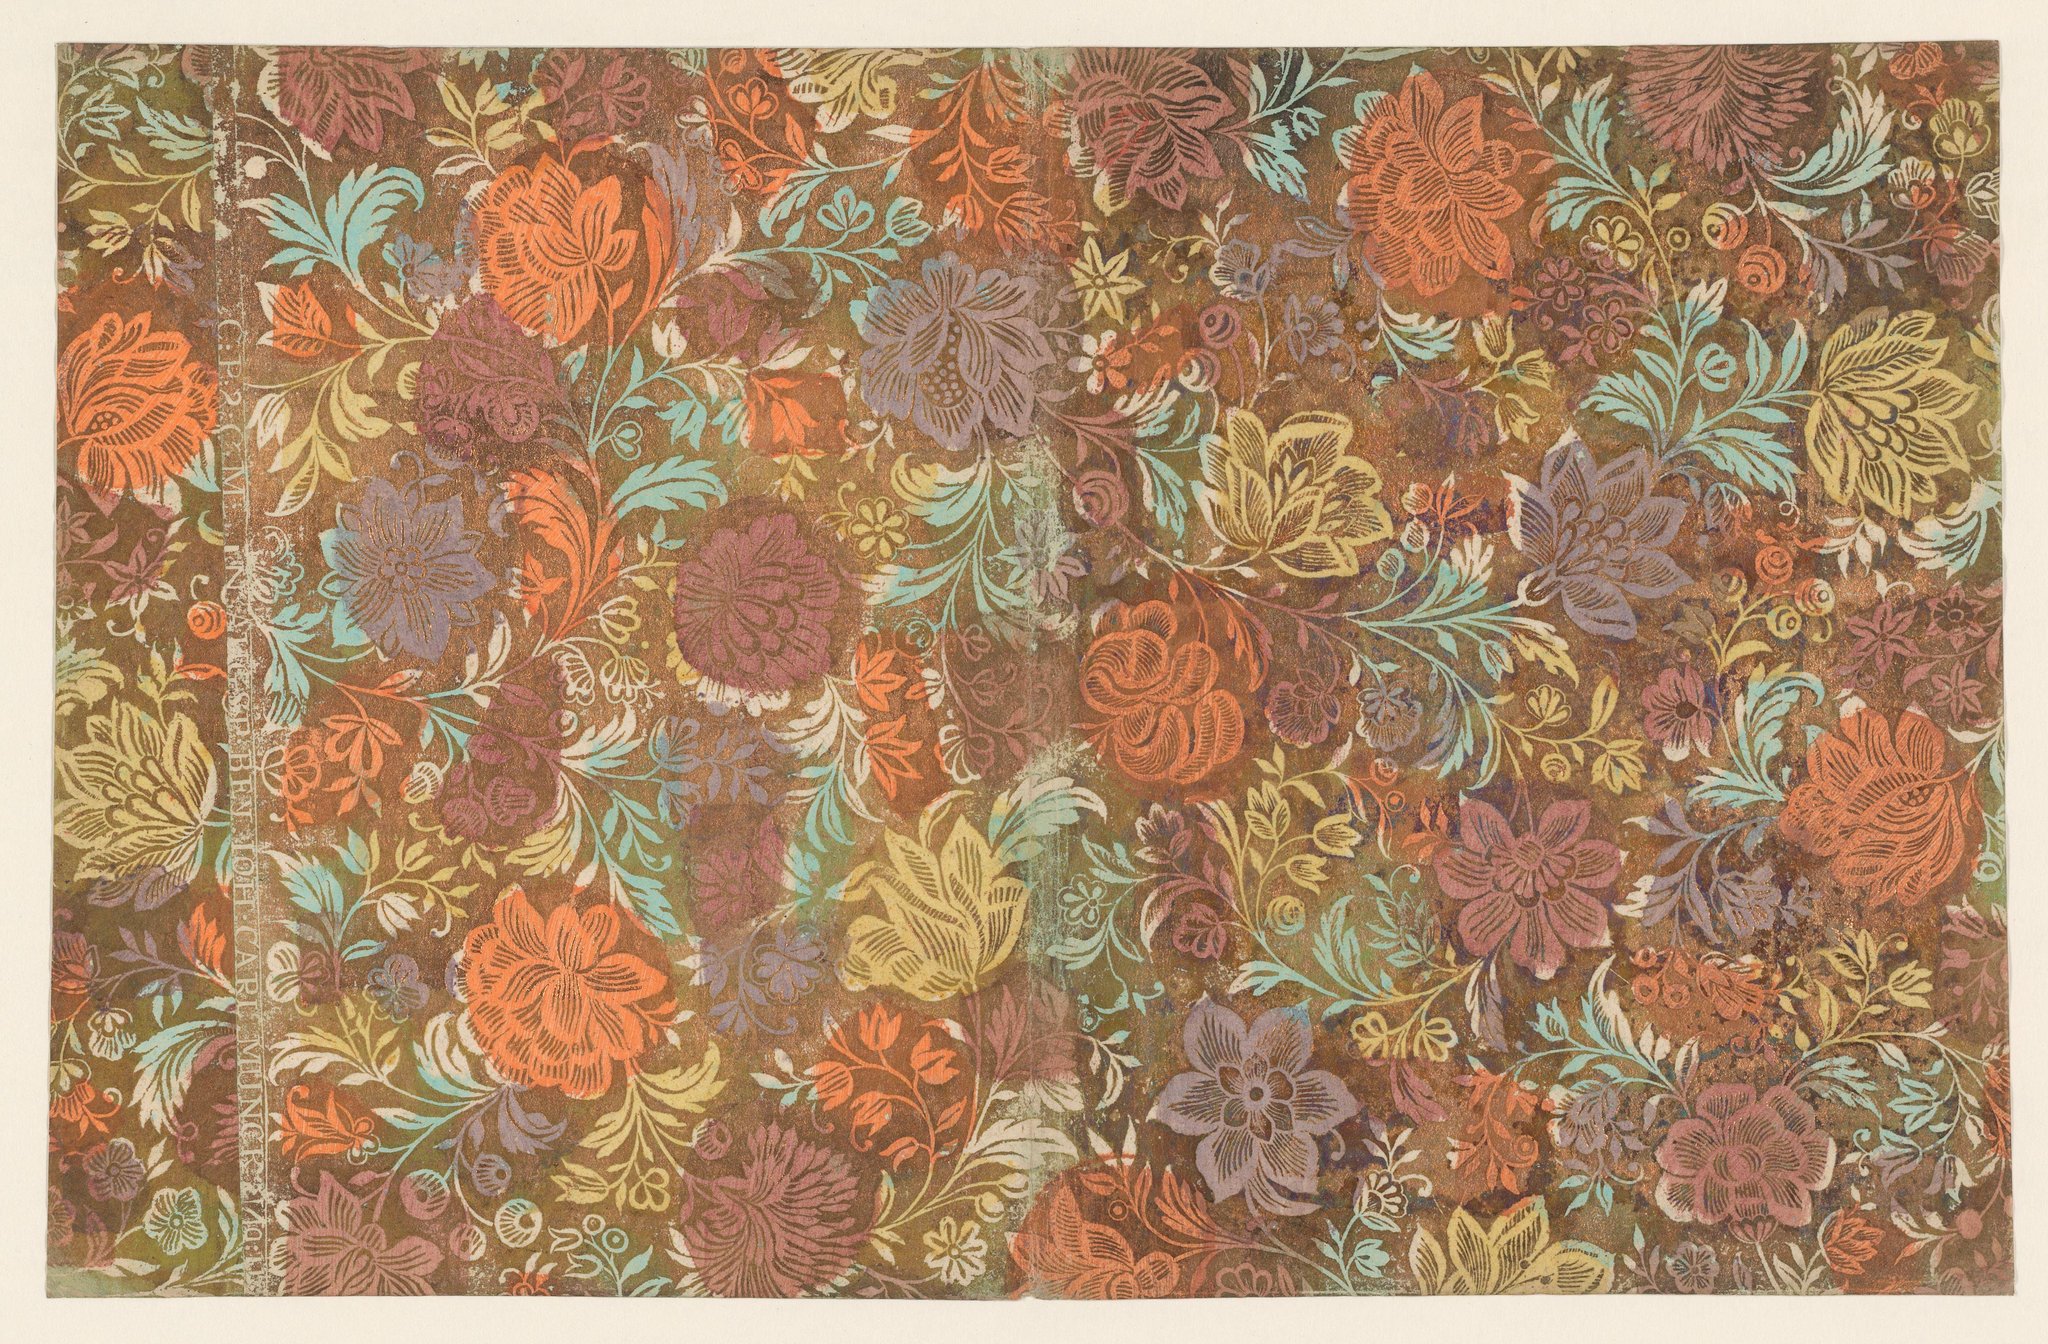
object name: brocade paper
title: Blad met bloemranken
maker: johann carl munck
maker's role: ontwerper sierpapier, papiermaker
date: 1750-1794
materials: gold leaf, paint, paper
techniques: relief print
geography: augsburg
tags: ornament derived from plant forms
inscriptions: address: ‘C:P:S C:M: IN AUGSP: BEY IOH: CARL. MUNCK NO: 11’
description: Blad met bloemranken. Links het adres. Gebruikt als omslag.